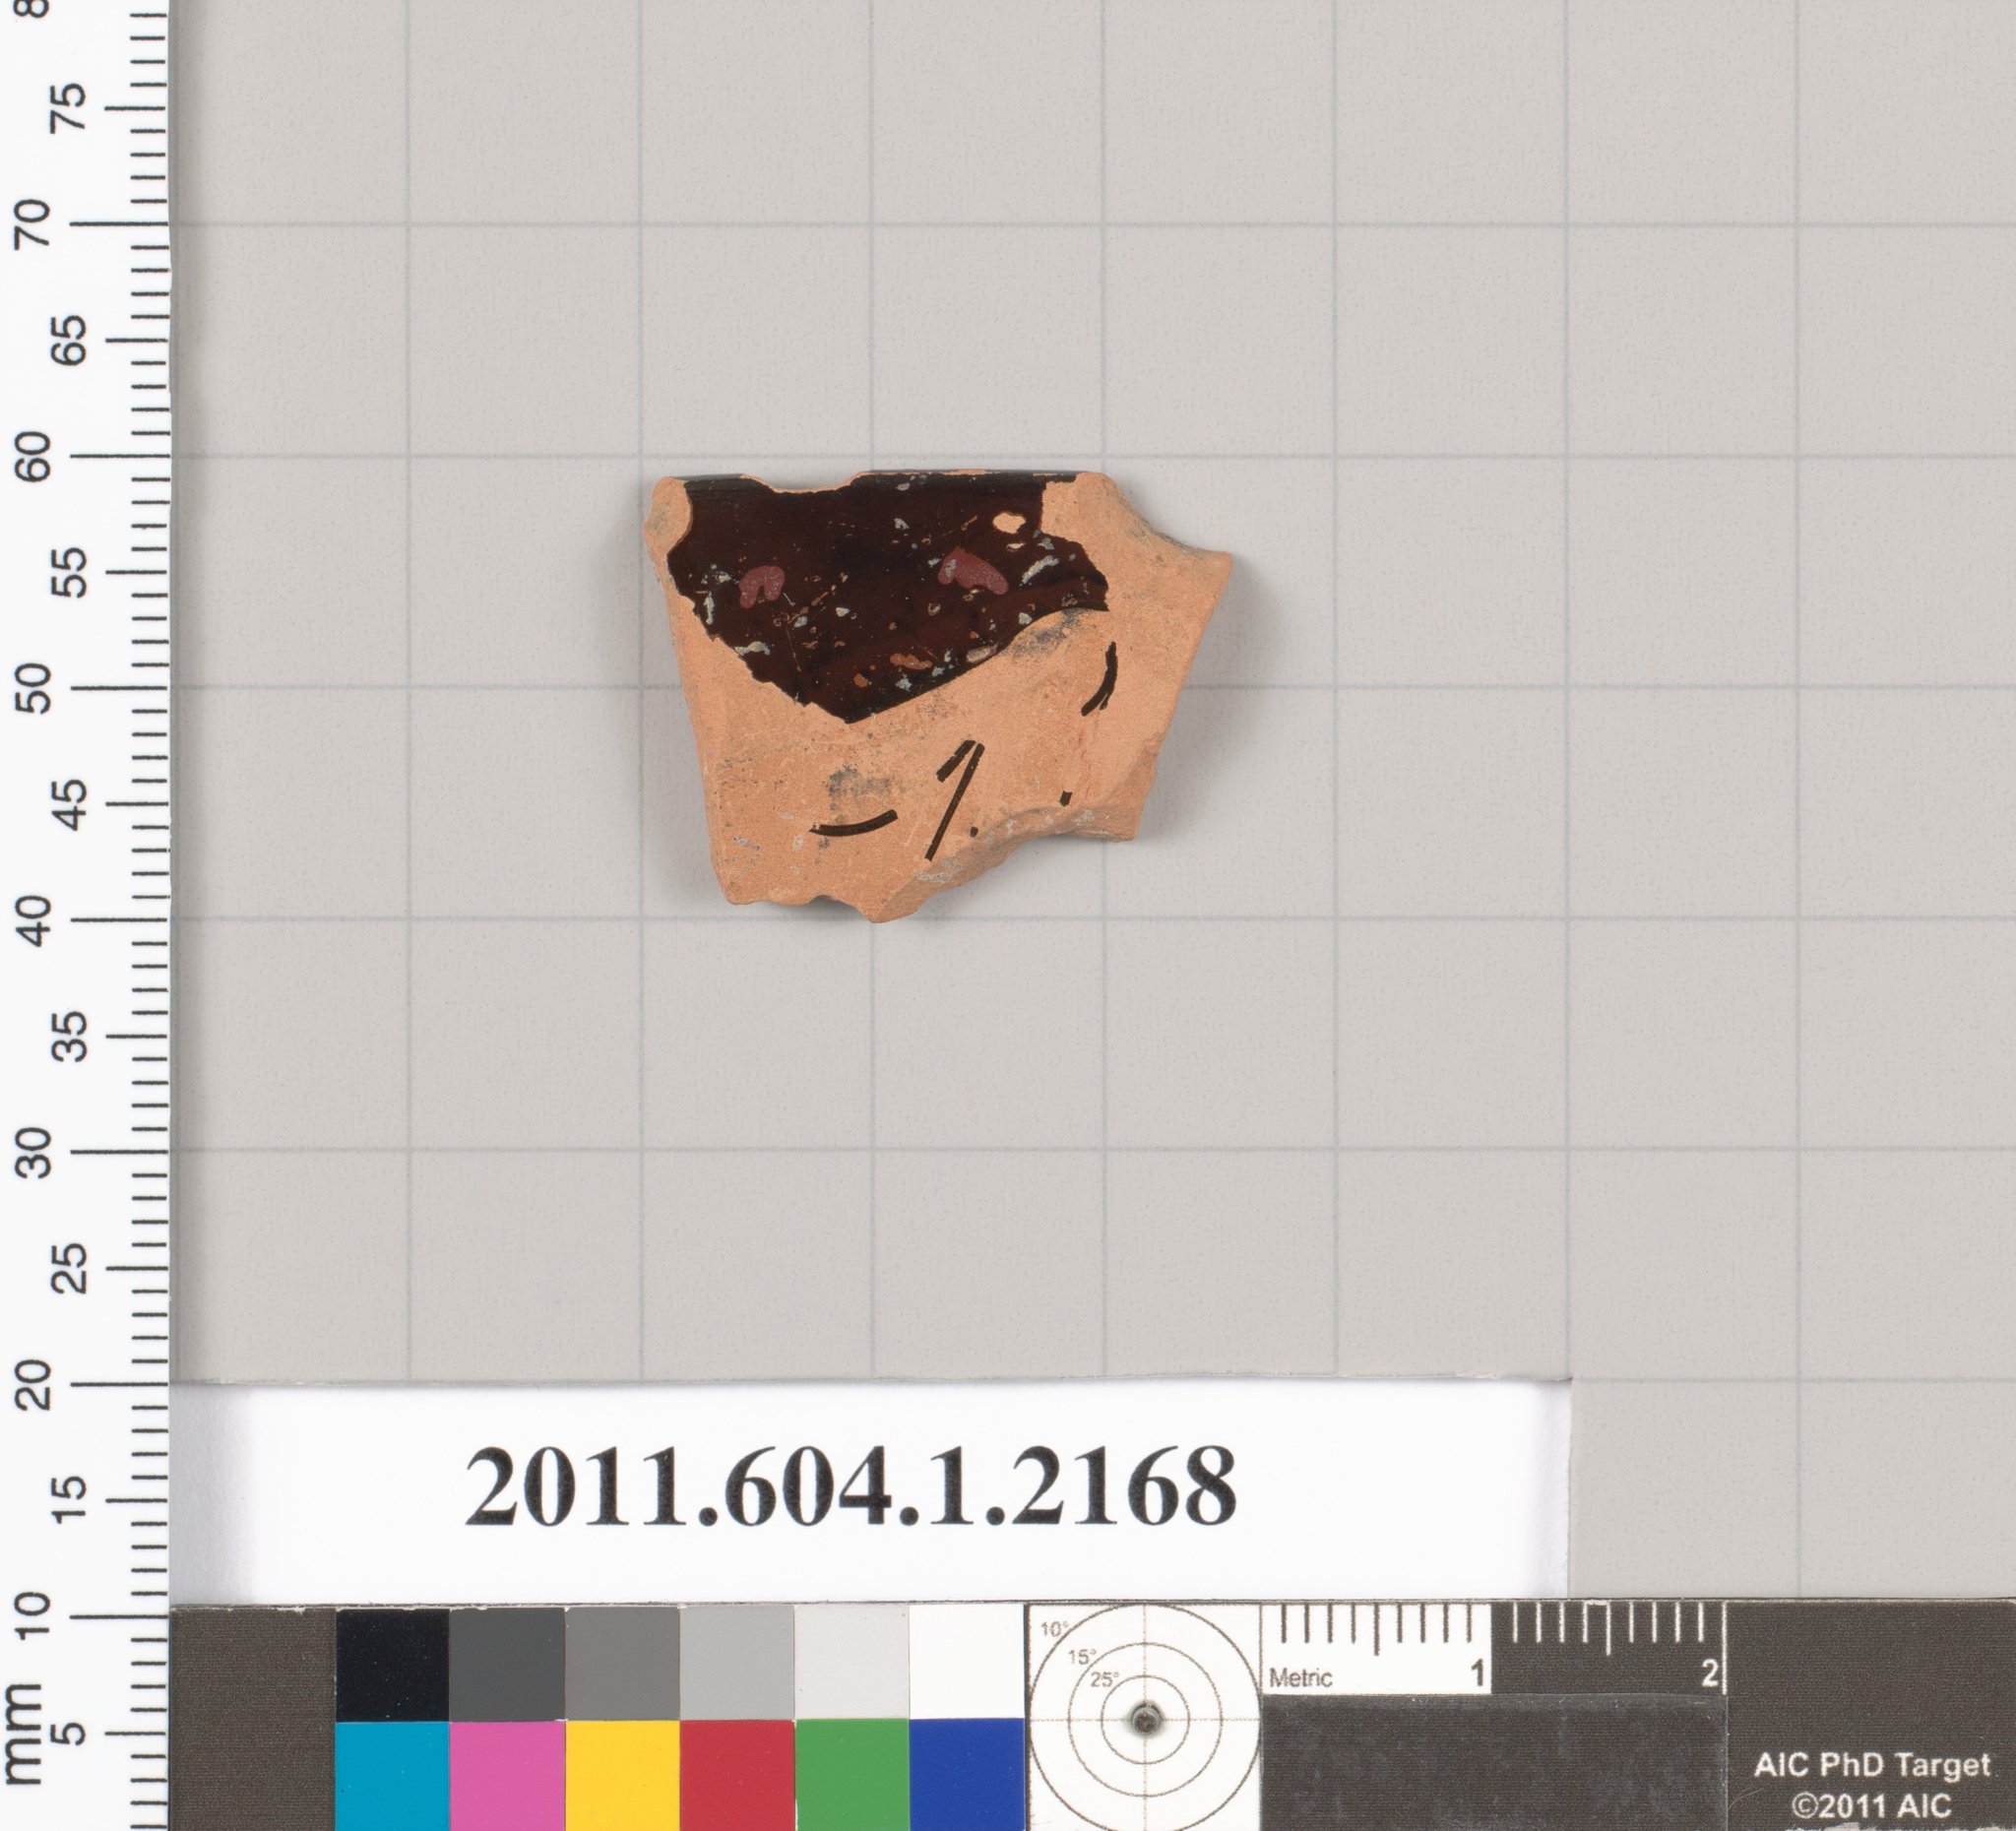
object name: kylix fragment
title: Terracotta rim fragment of a kylix (drinking cup)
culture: greek, attic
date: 500-451 BCE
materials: terracotta